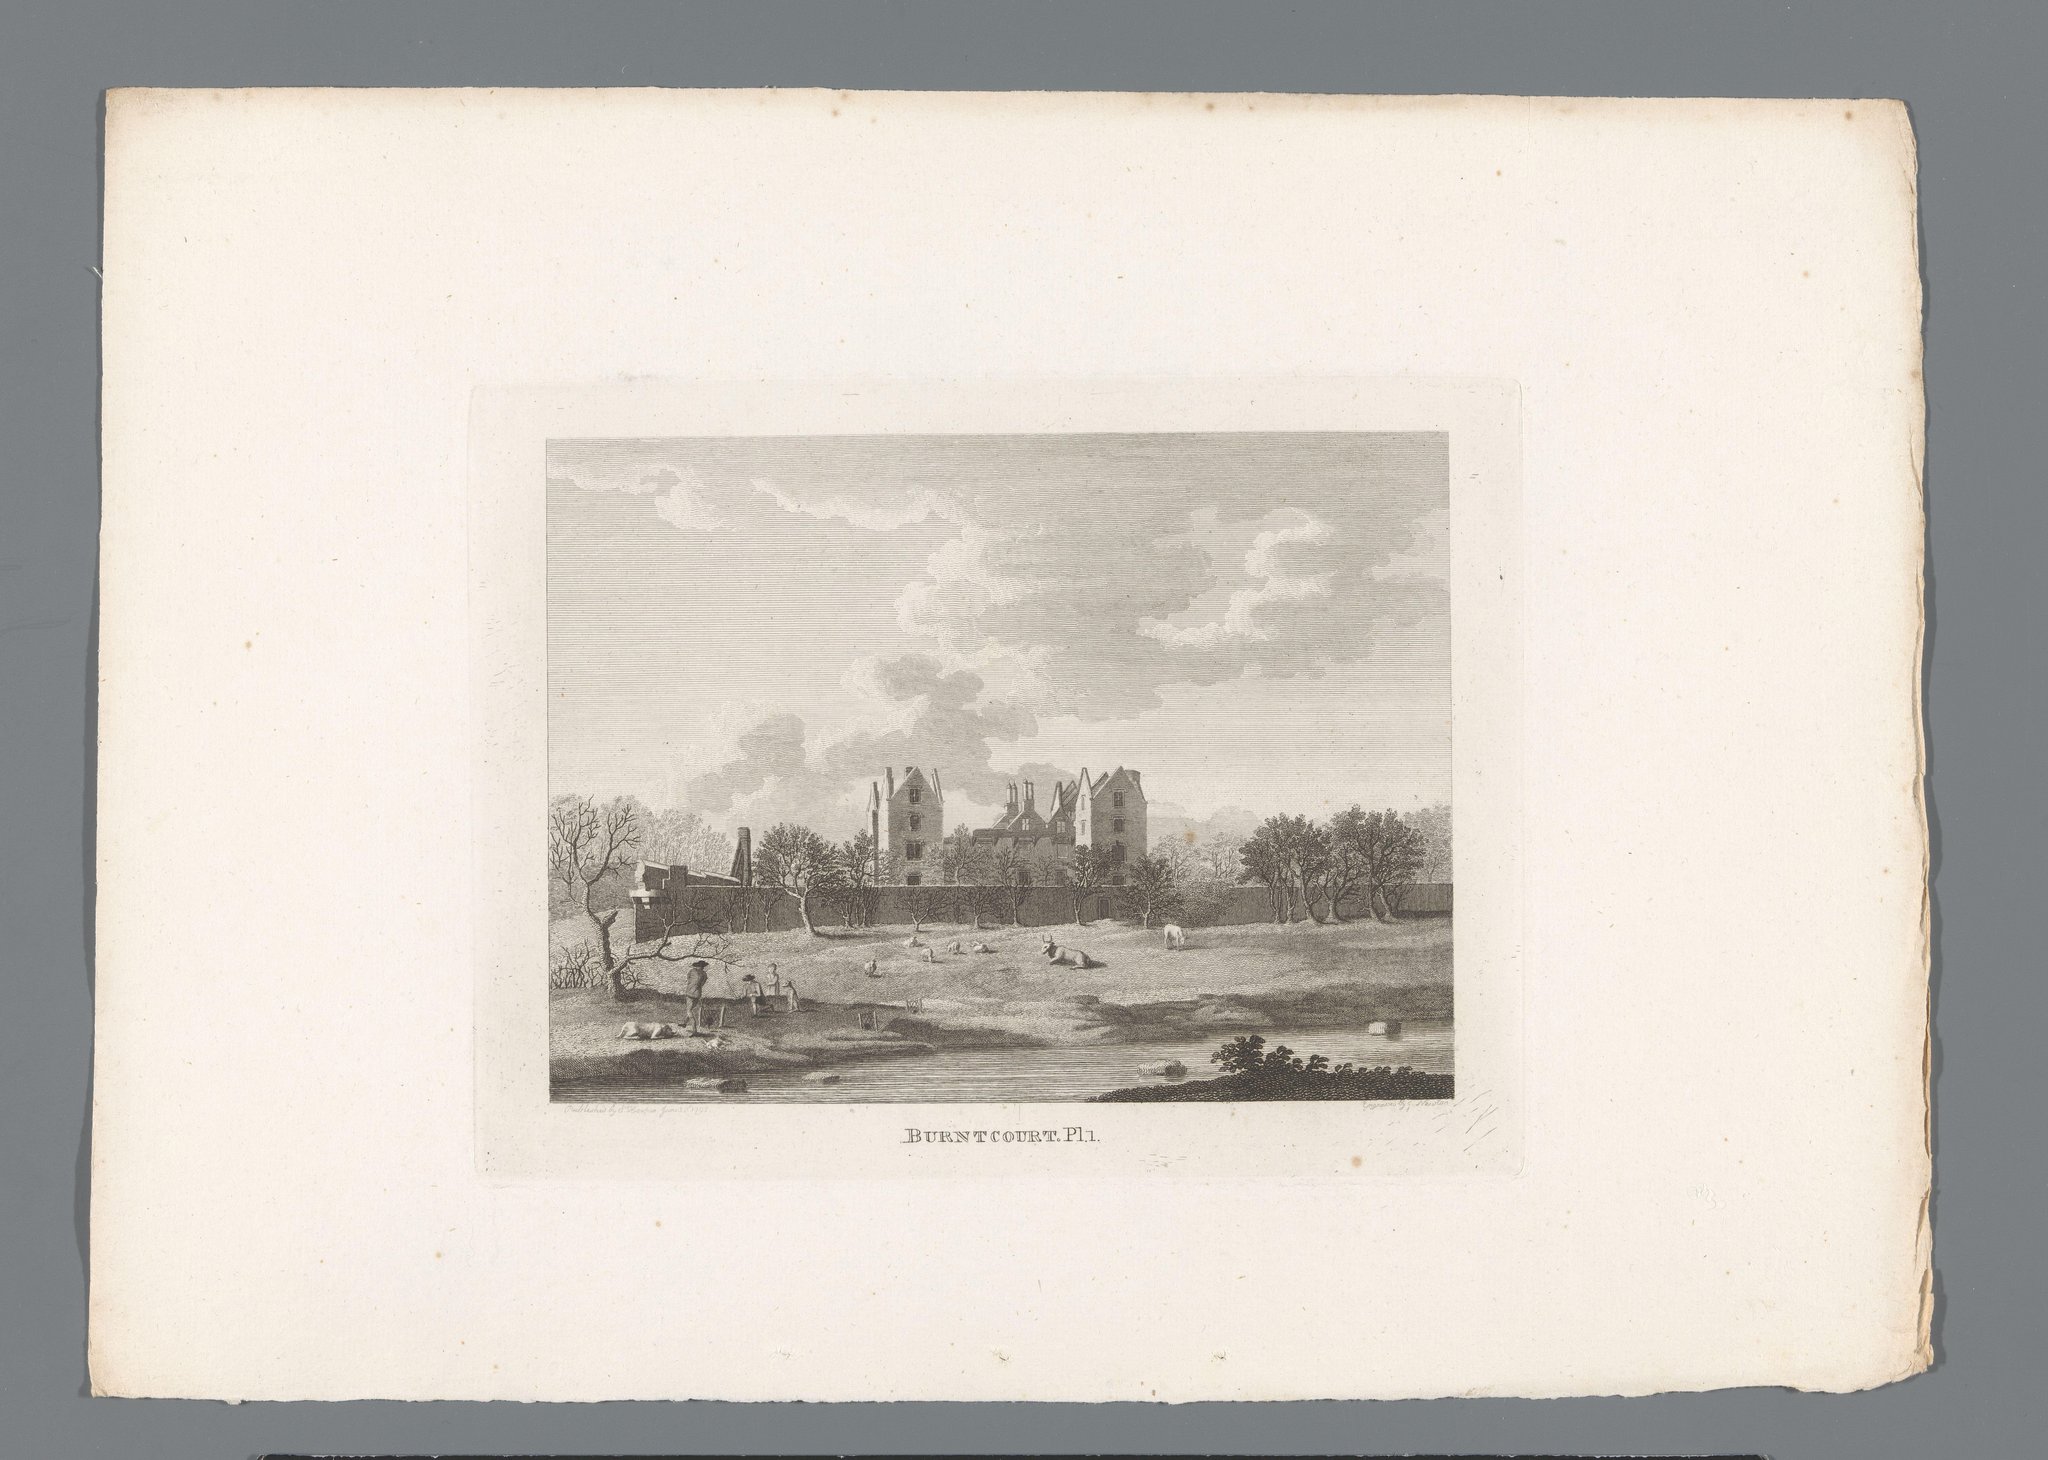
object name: book illustration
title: Gezicht op de ruïnes van het kasteel van Burncourt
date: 1792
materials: paper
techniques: etching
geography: london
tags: landscape with ruins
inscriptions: date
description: Prent verschenen in: Grose, Francis. The antiquities of Ireland. Londen: S. Hooper, 1795, dl. 2.